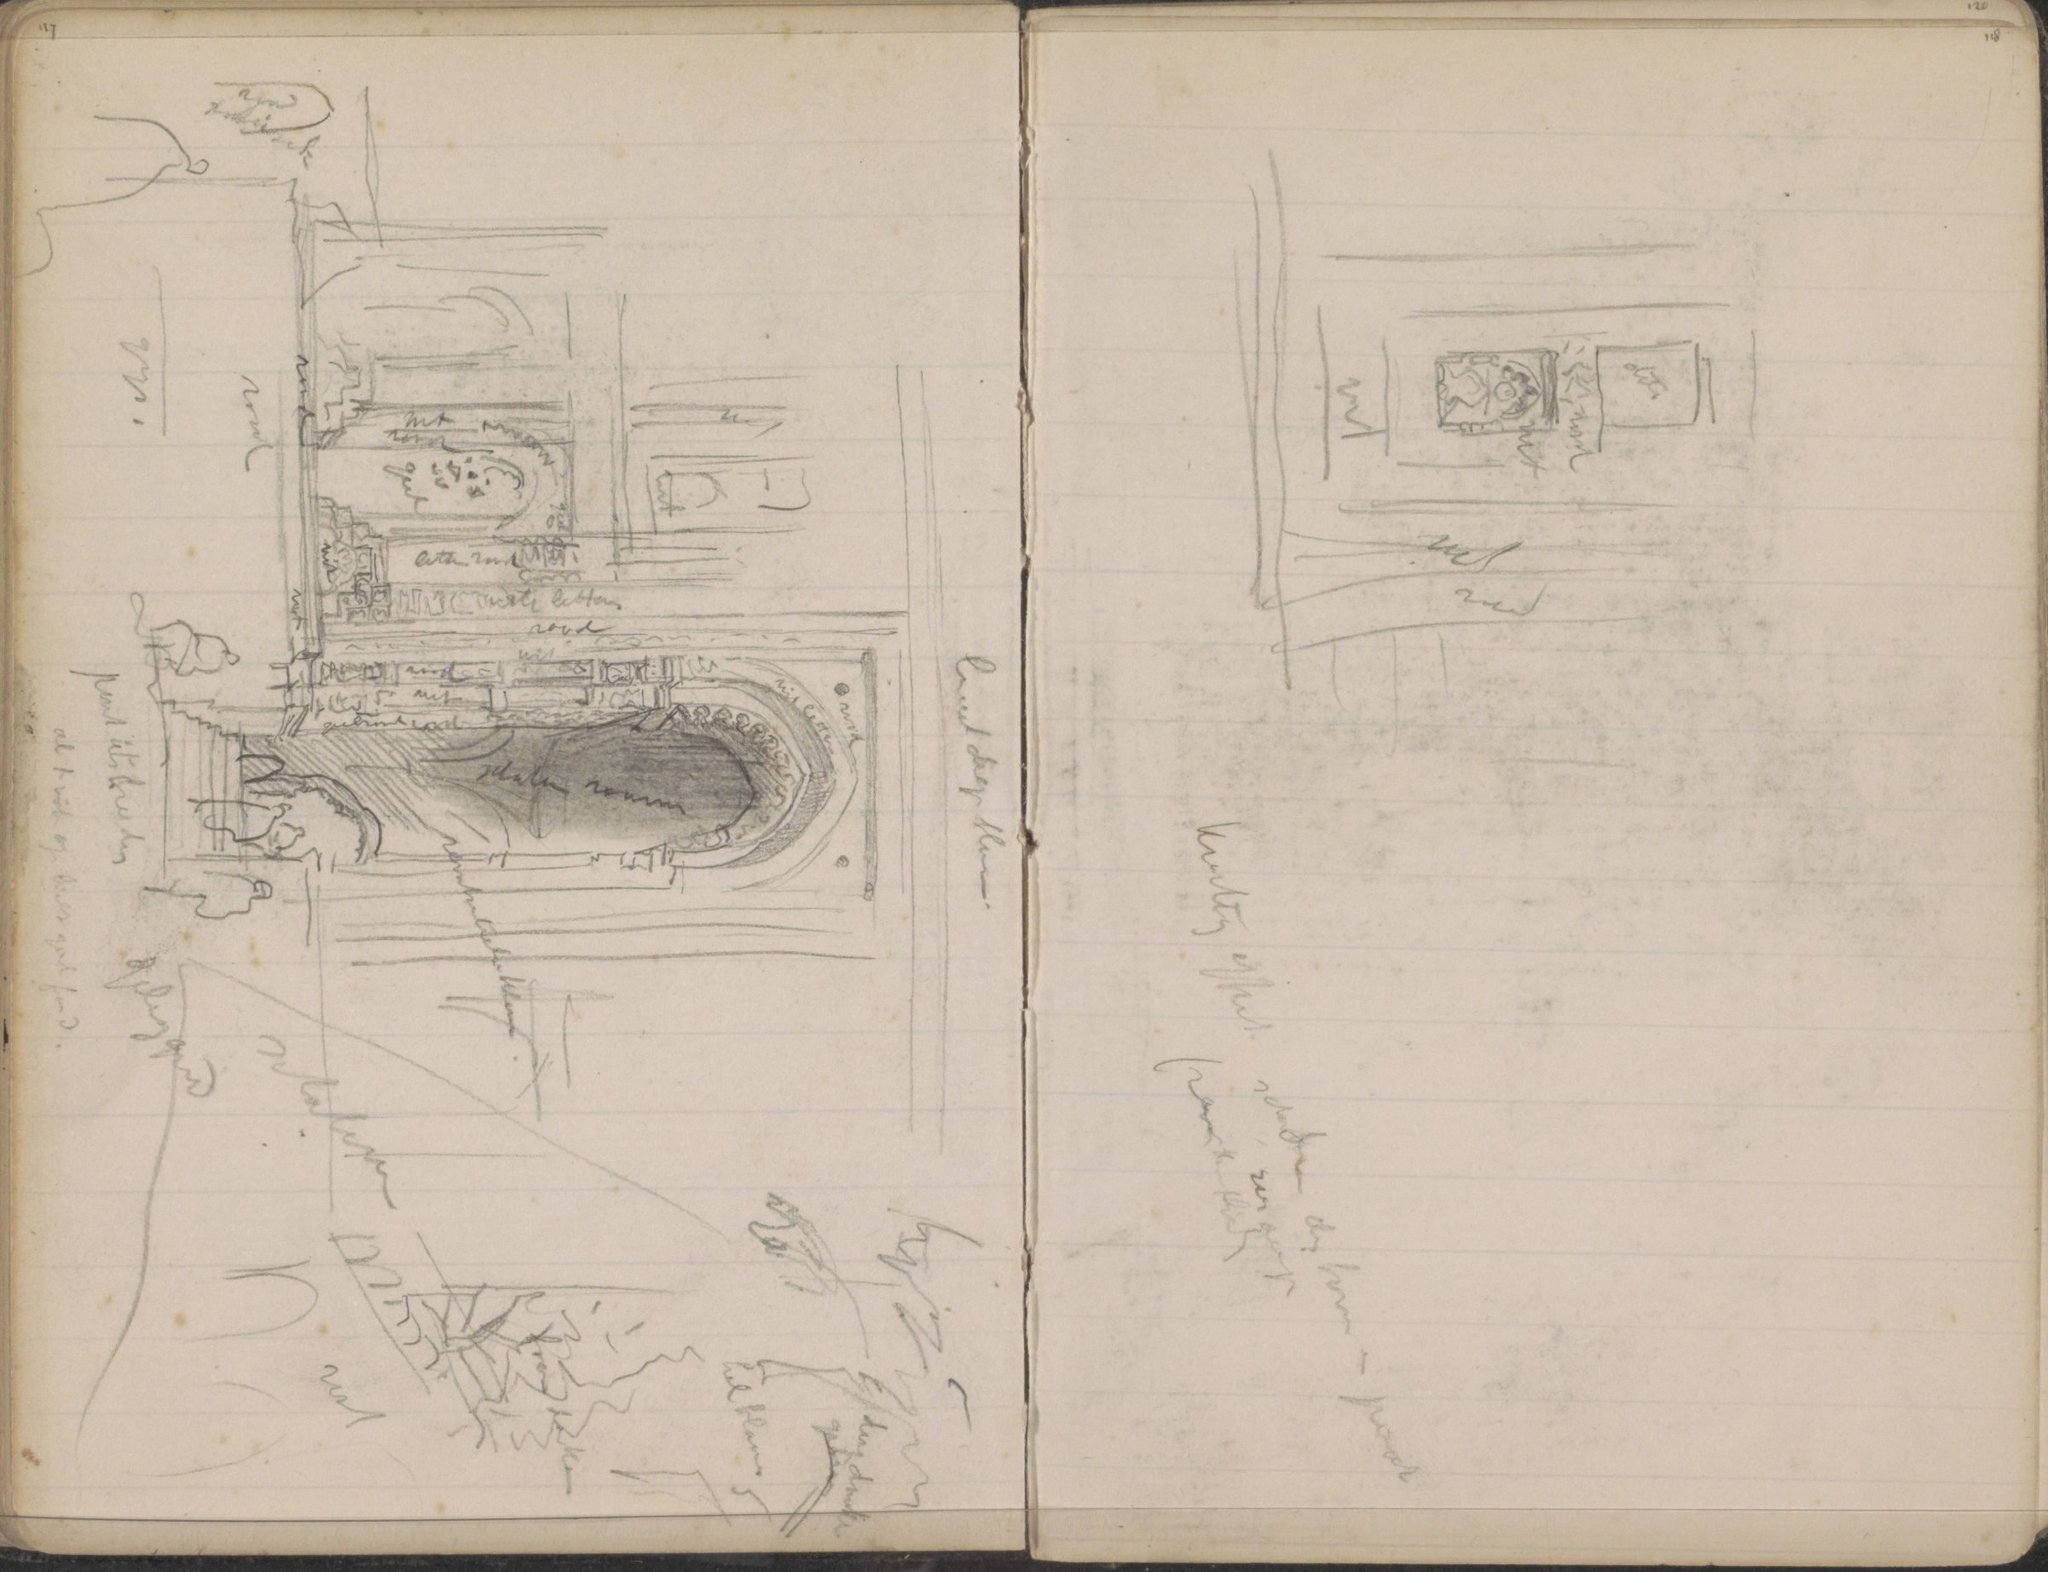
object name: sketchbook leaf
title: Figuren bij een trap voor een portaal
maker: marius bauer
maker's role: draughtsman, print maker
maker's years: 1867-1932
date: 1897-1898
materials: pencil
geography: delhi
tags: flight of steps, anatomy (non-medical), arch, archivolt ~ architecture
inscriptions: kleurnotitie, handgeschreven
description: Pagina 117 uit een schetsboek met 84 bladen.